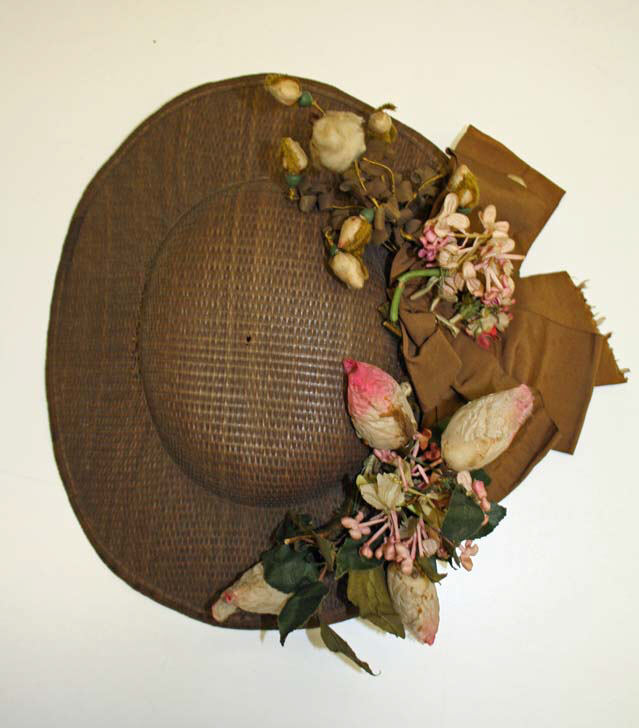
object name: hat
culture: american or european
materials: fiber